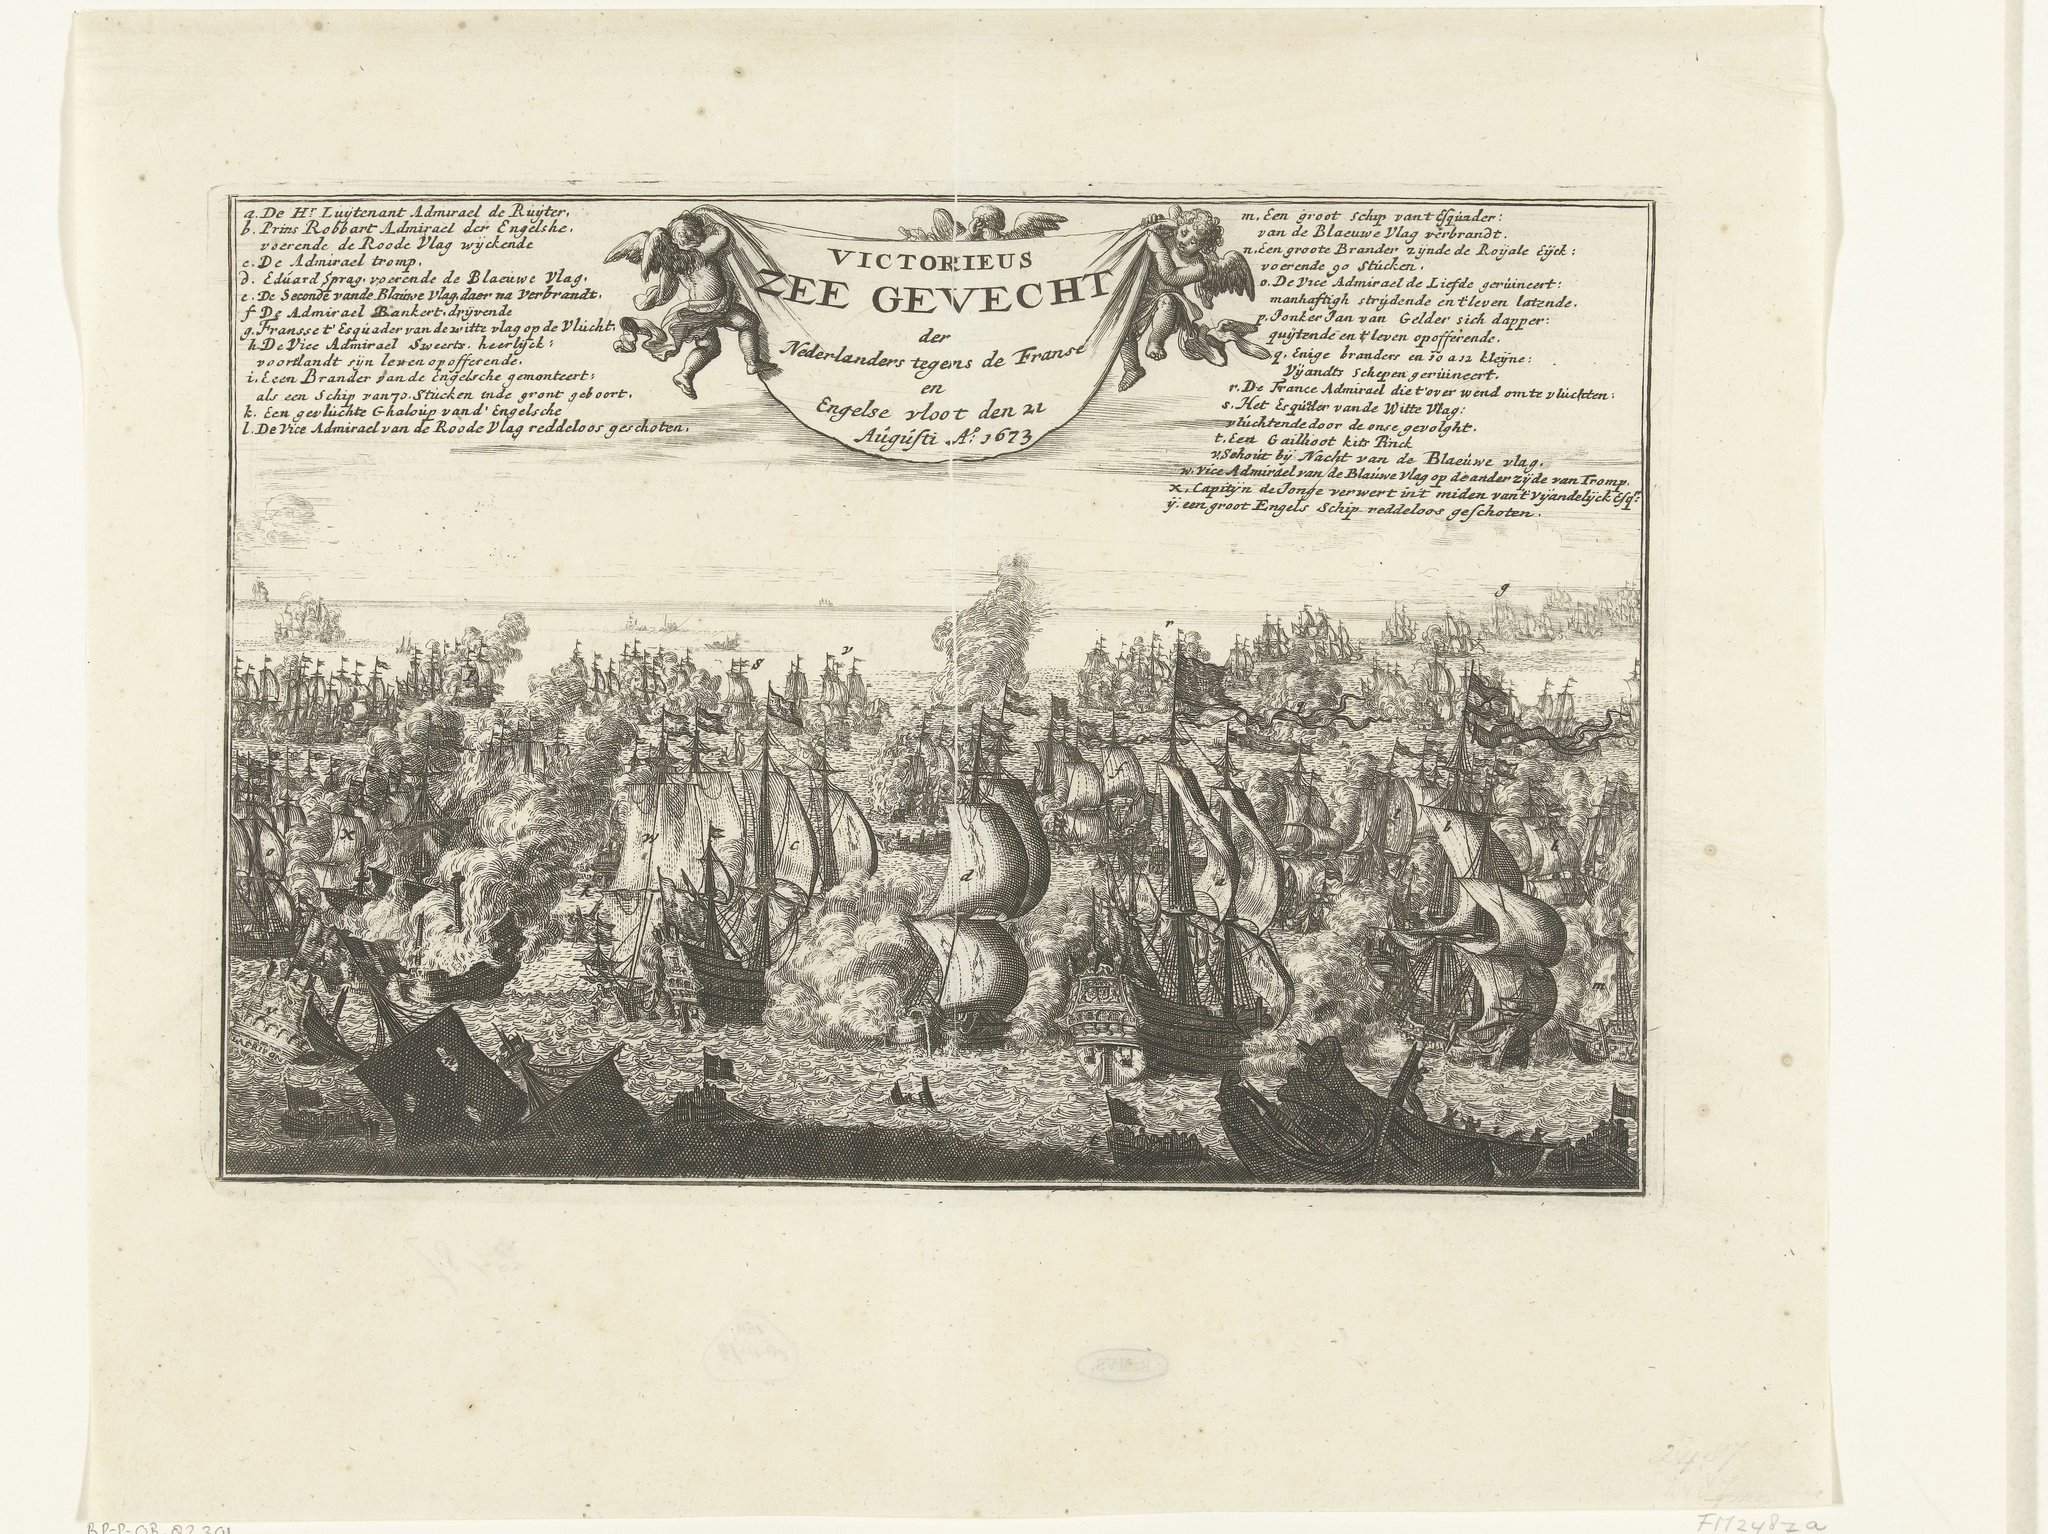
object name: print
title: Zeeslag bij Kijkduin, 21 augustus 1673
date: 1674-1676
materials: paper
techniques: engraving, etching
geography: northern netherlands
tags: prague, london, painter, print maker, draughtsman, prinz ruprecht, flushing, michiel adriaenszoon de ruyter, rotterdam, cornelis tromp, battle (+ naval force), battle of the texel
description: Zeeslag bij Kijkduin (bij Texel) op 21 augustus 1673 tussen de Staatse vloot onder Michiel Adriaenszoon de Ruyter en Cornelis Tromp en de Engels-Franse vloot onder prins Rupert en graaf Jean d'Estrées (II). Bovenaan houden engelen een doek met titel omhoog. Links en rechts de legenda a-y.